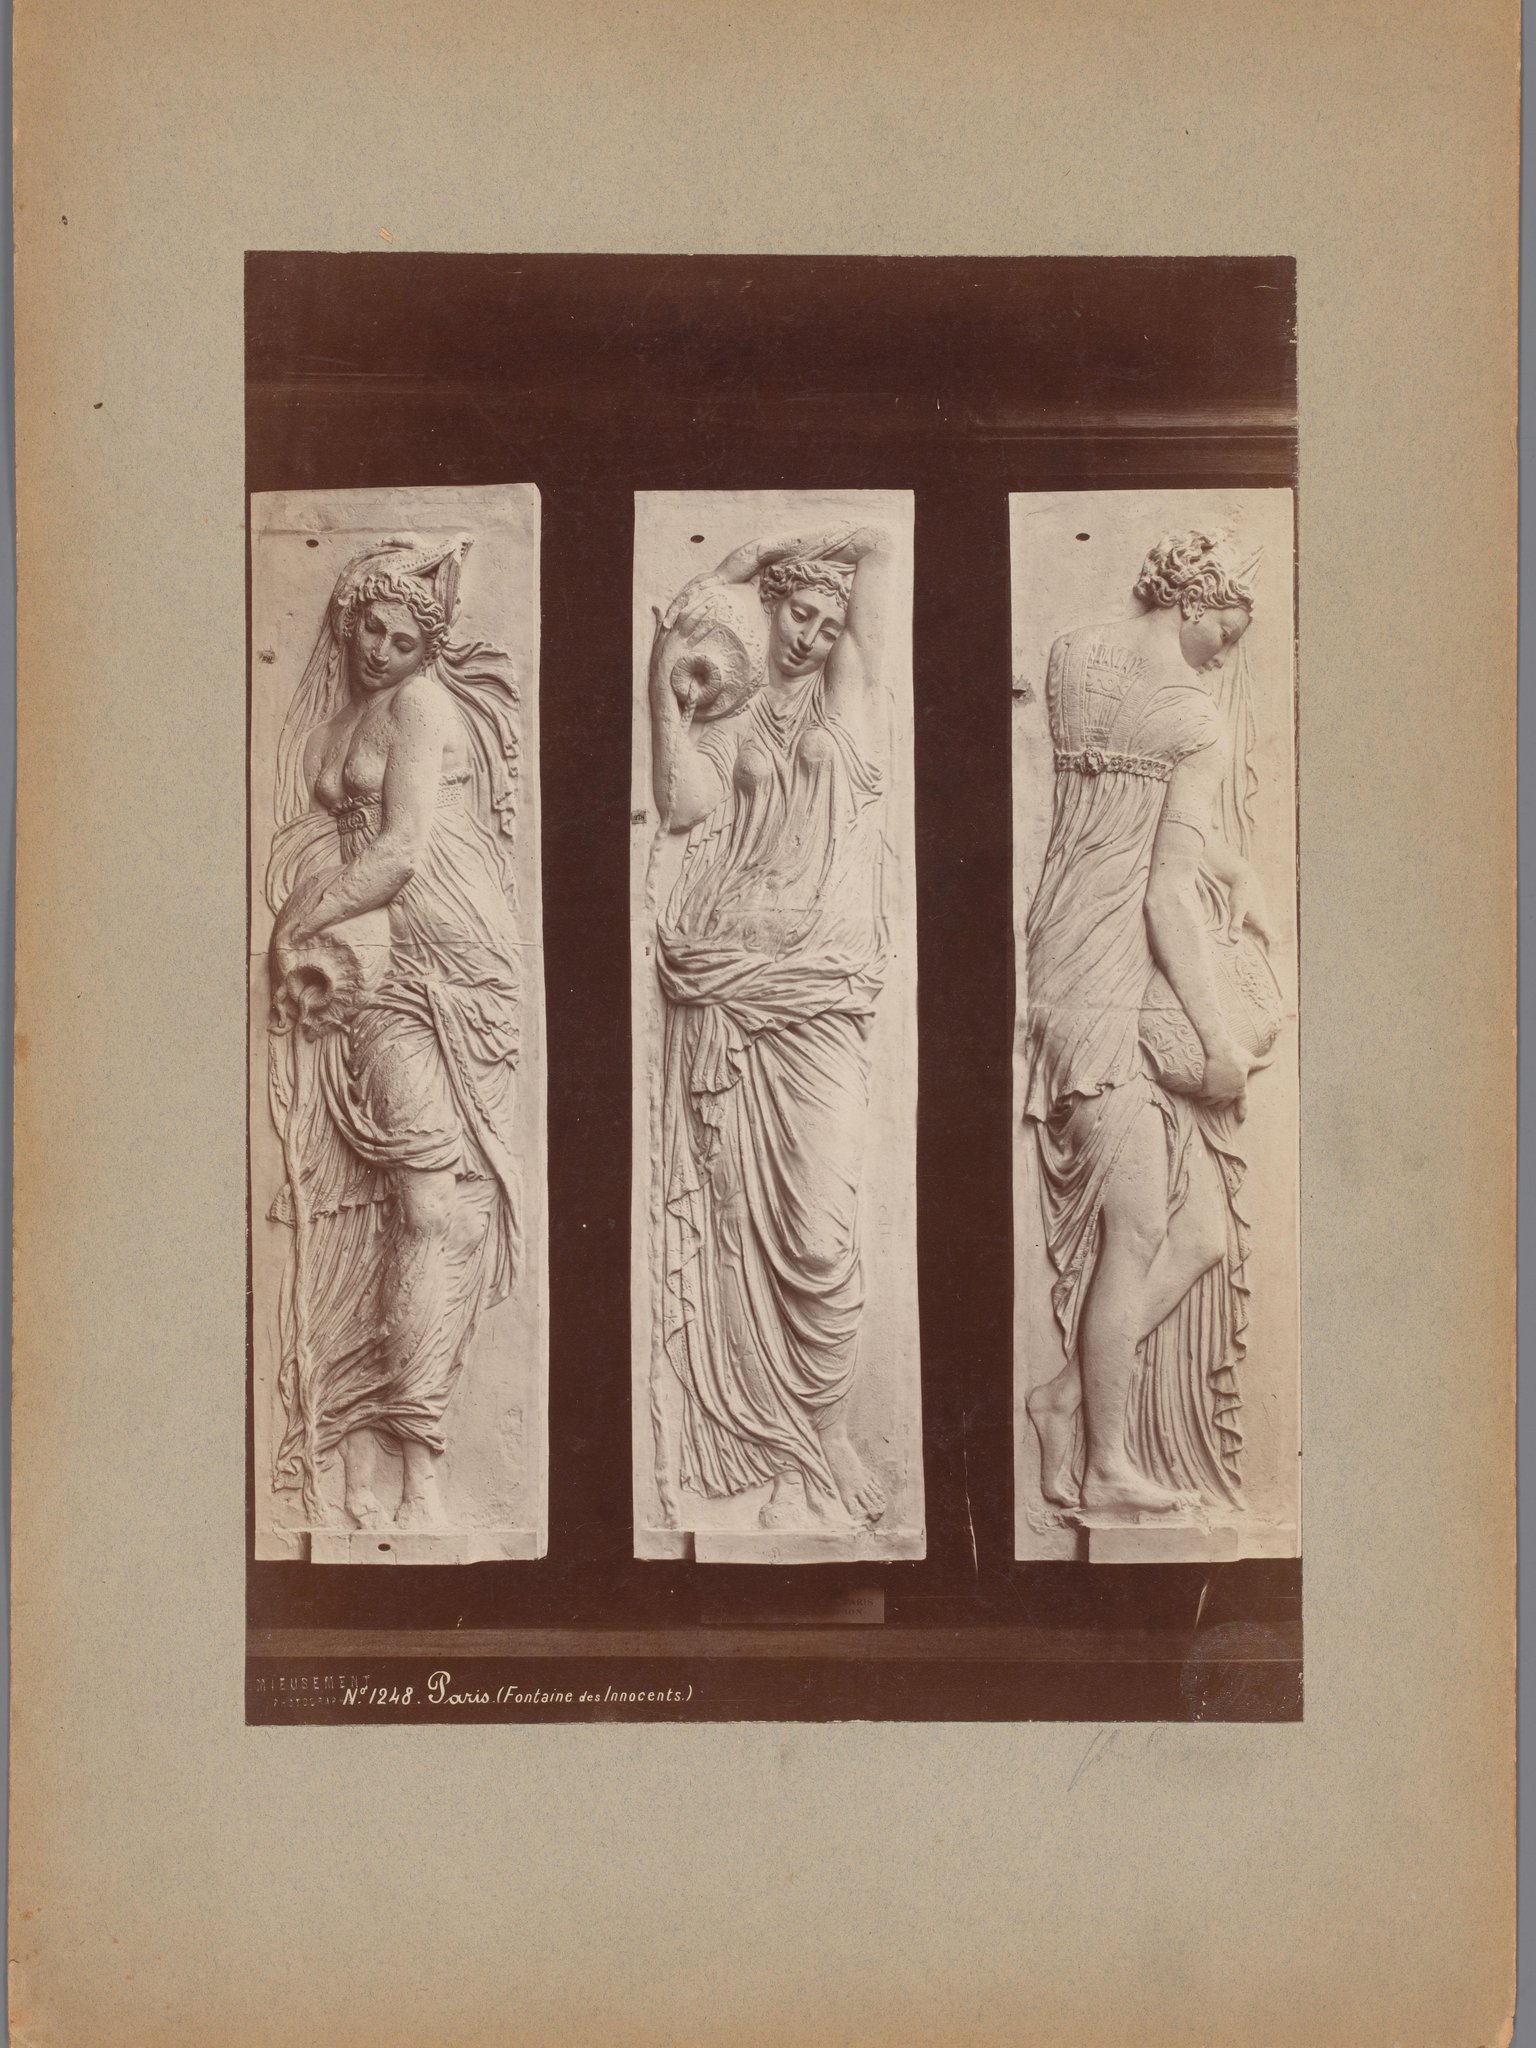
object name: photograph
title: Fontaine des Innocents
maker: séraphin-médéric mieusement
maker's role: fotograaf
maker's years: 1840-1905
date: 1850-1900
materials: cardboard, photographic support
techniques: albumen print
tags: sculpture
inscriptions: workshop stamp: ‘MIEUSEMENT/ photographe’, collector's mark: ‘[...]’, retailer's mark: ‘Kunstboekhandel/ J.A.G. De Leur/ Photograaf- Uitgever/ Huigenspark, 40b./ Den Haag’, number: ‘No. 1250’, collector's mark: ‘Rijks normaalschool voor teekenonderwijzers Amsterdam’